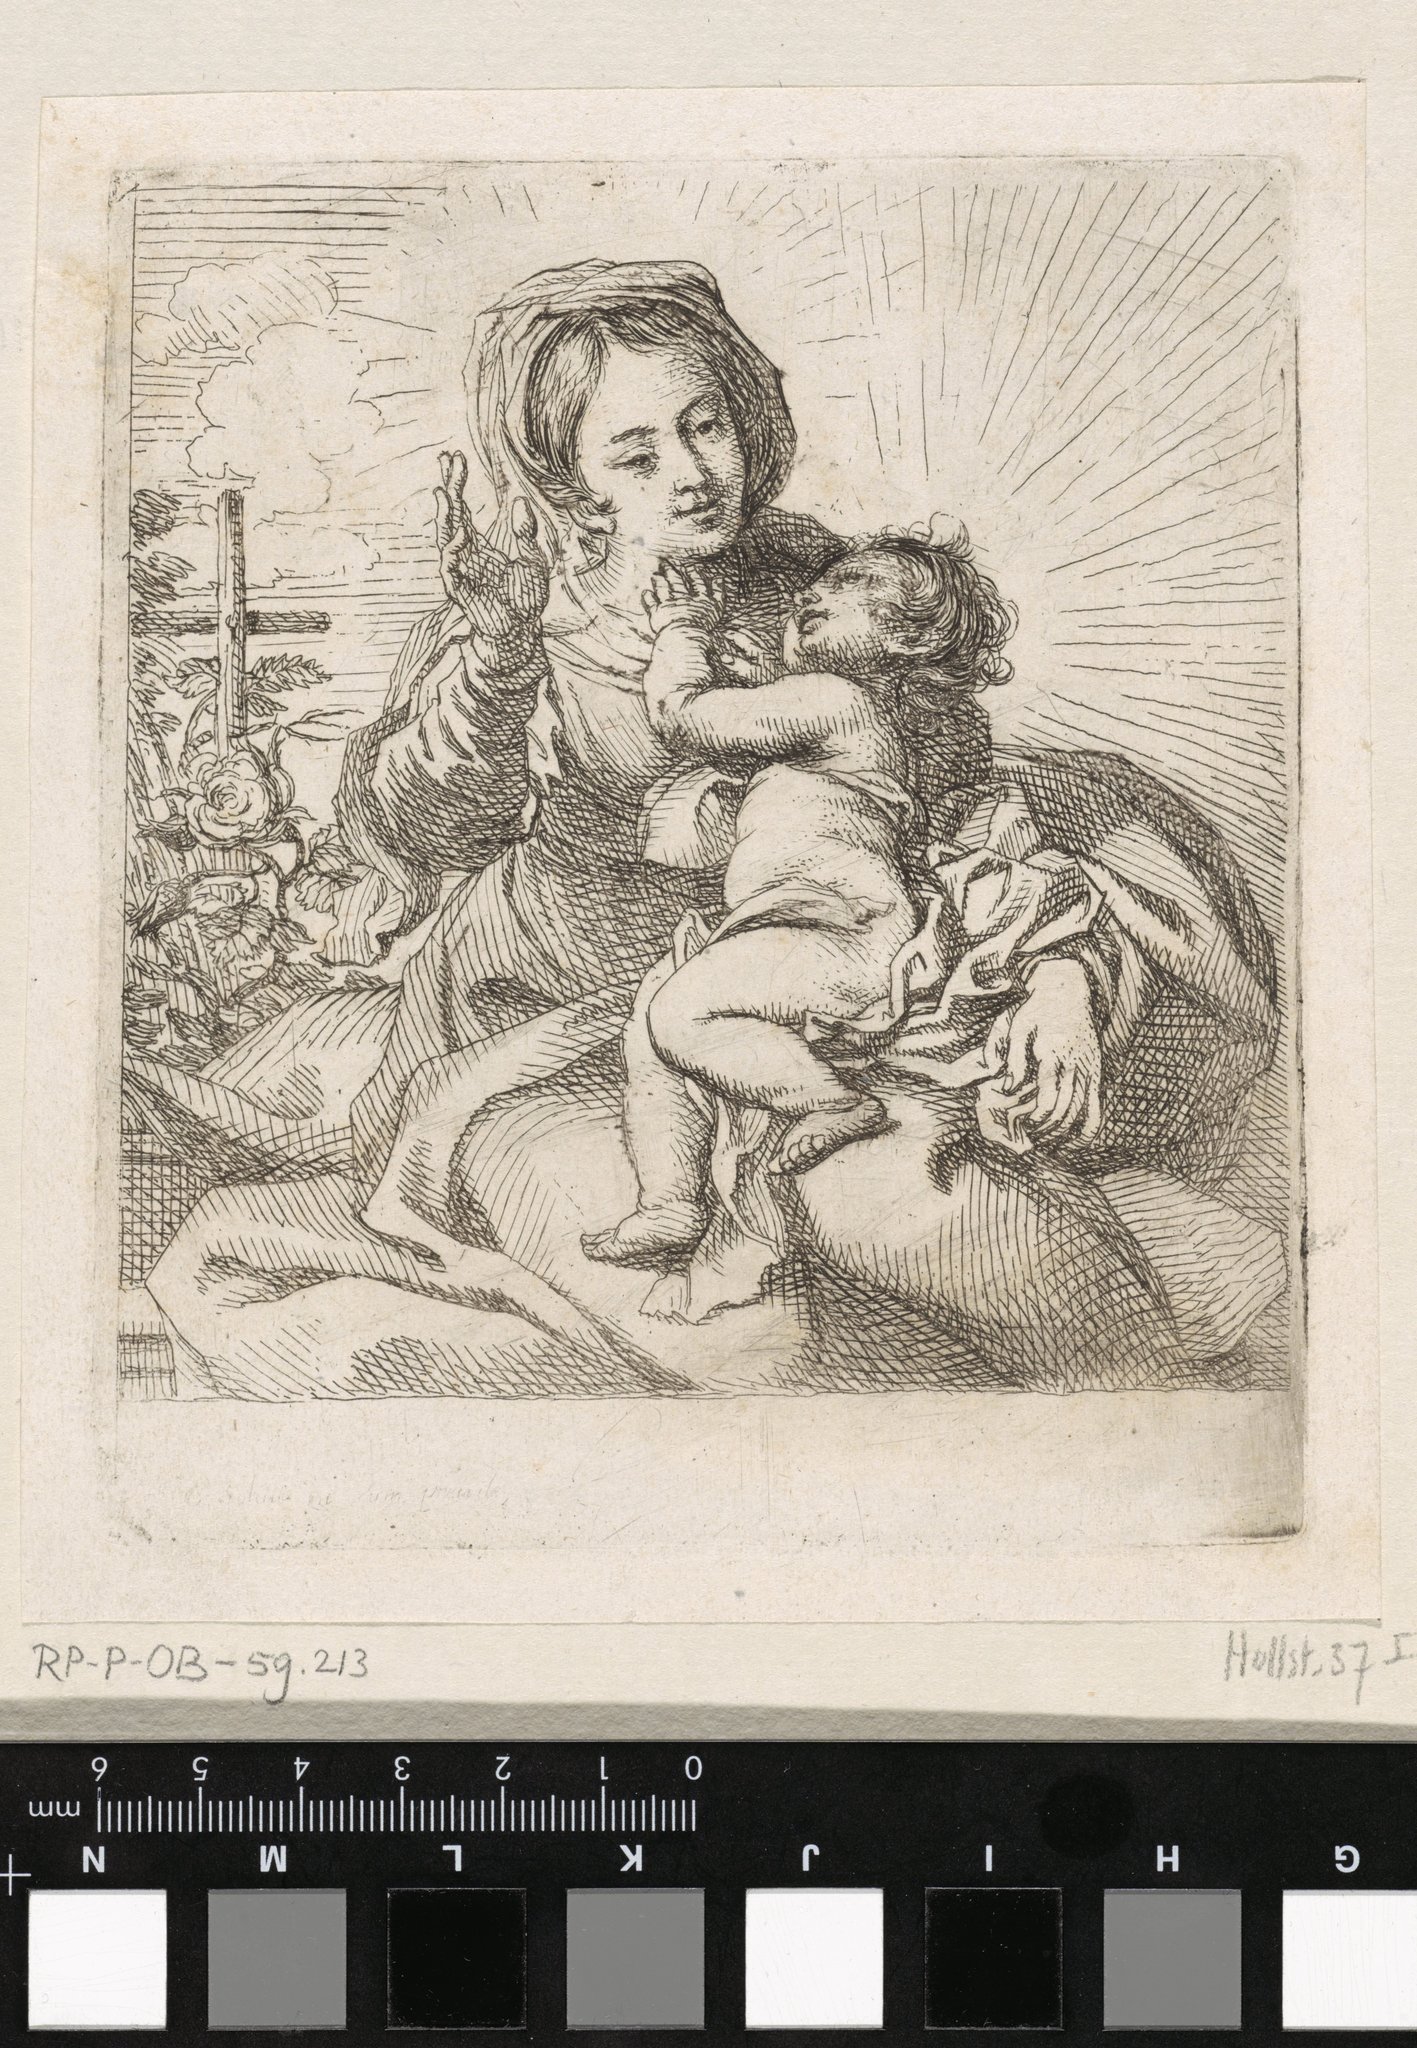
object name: print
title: Madonna met kind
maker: cornelis schut (i)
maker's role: draughtsman, print maker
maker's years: 1597-1655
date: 1618-1655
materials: paper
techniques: etching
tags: madonna: i.e. mary with the christ-child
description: Het Christuskind ligt op schoot bij Maria, zijn hoofd op haar schouder. Op de achtergrond het kruis waarlangs een rozenstruik zich naar boven slingert.